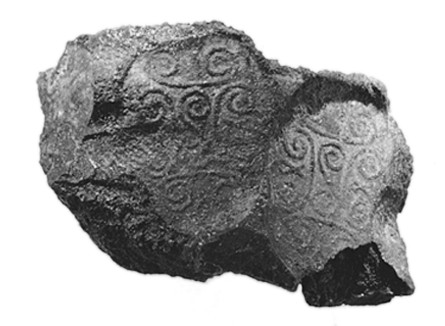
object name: sealing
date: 1981-1640 BCE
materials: mud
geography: egypt